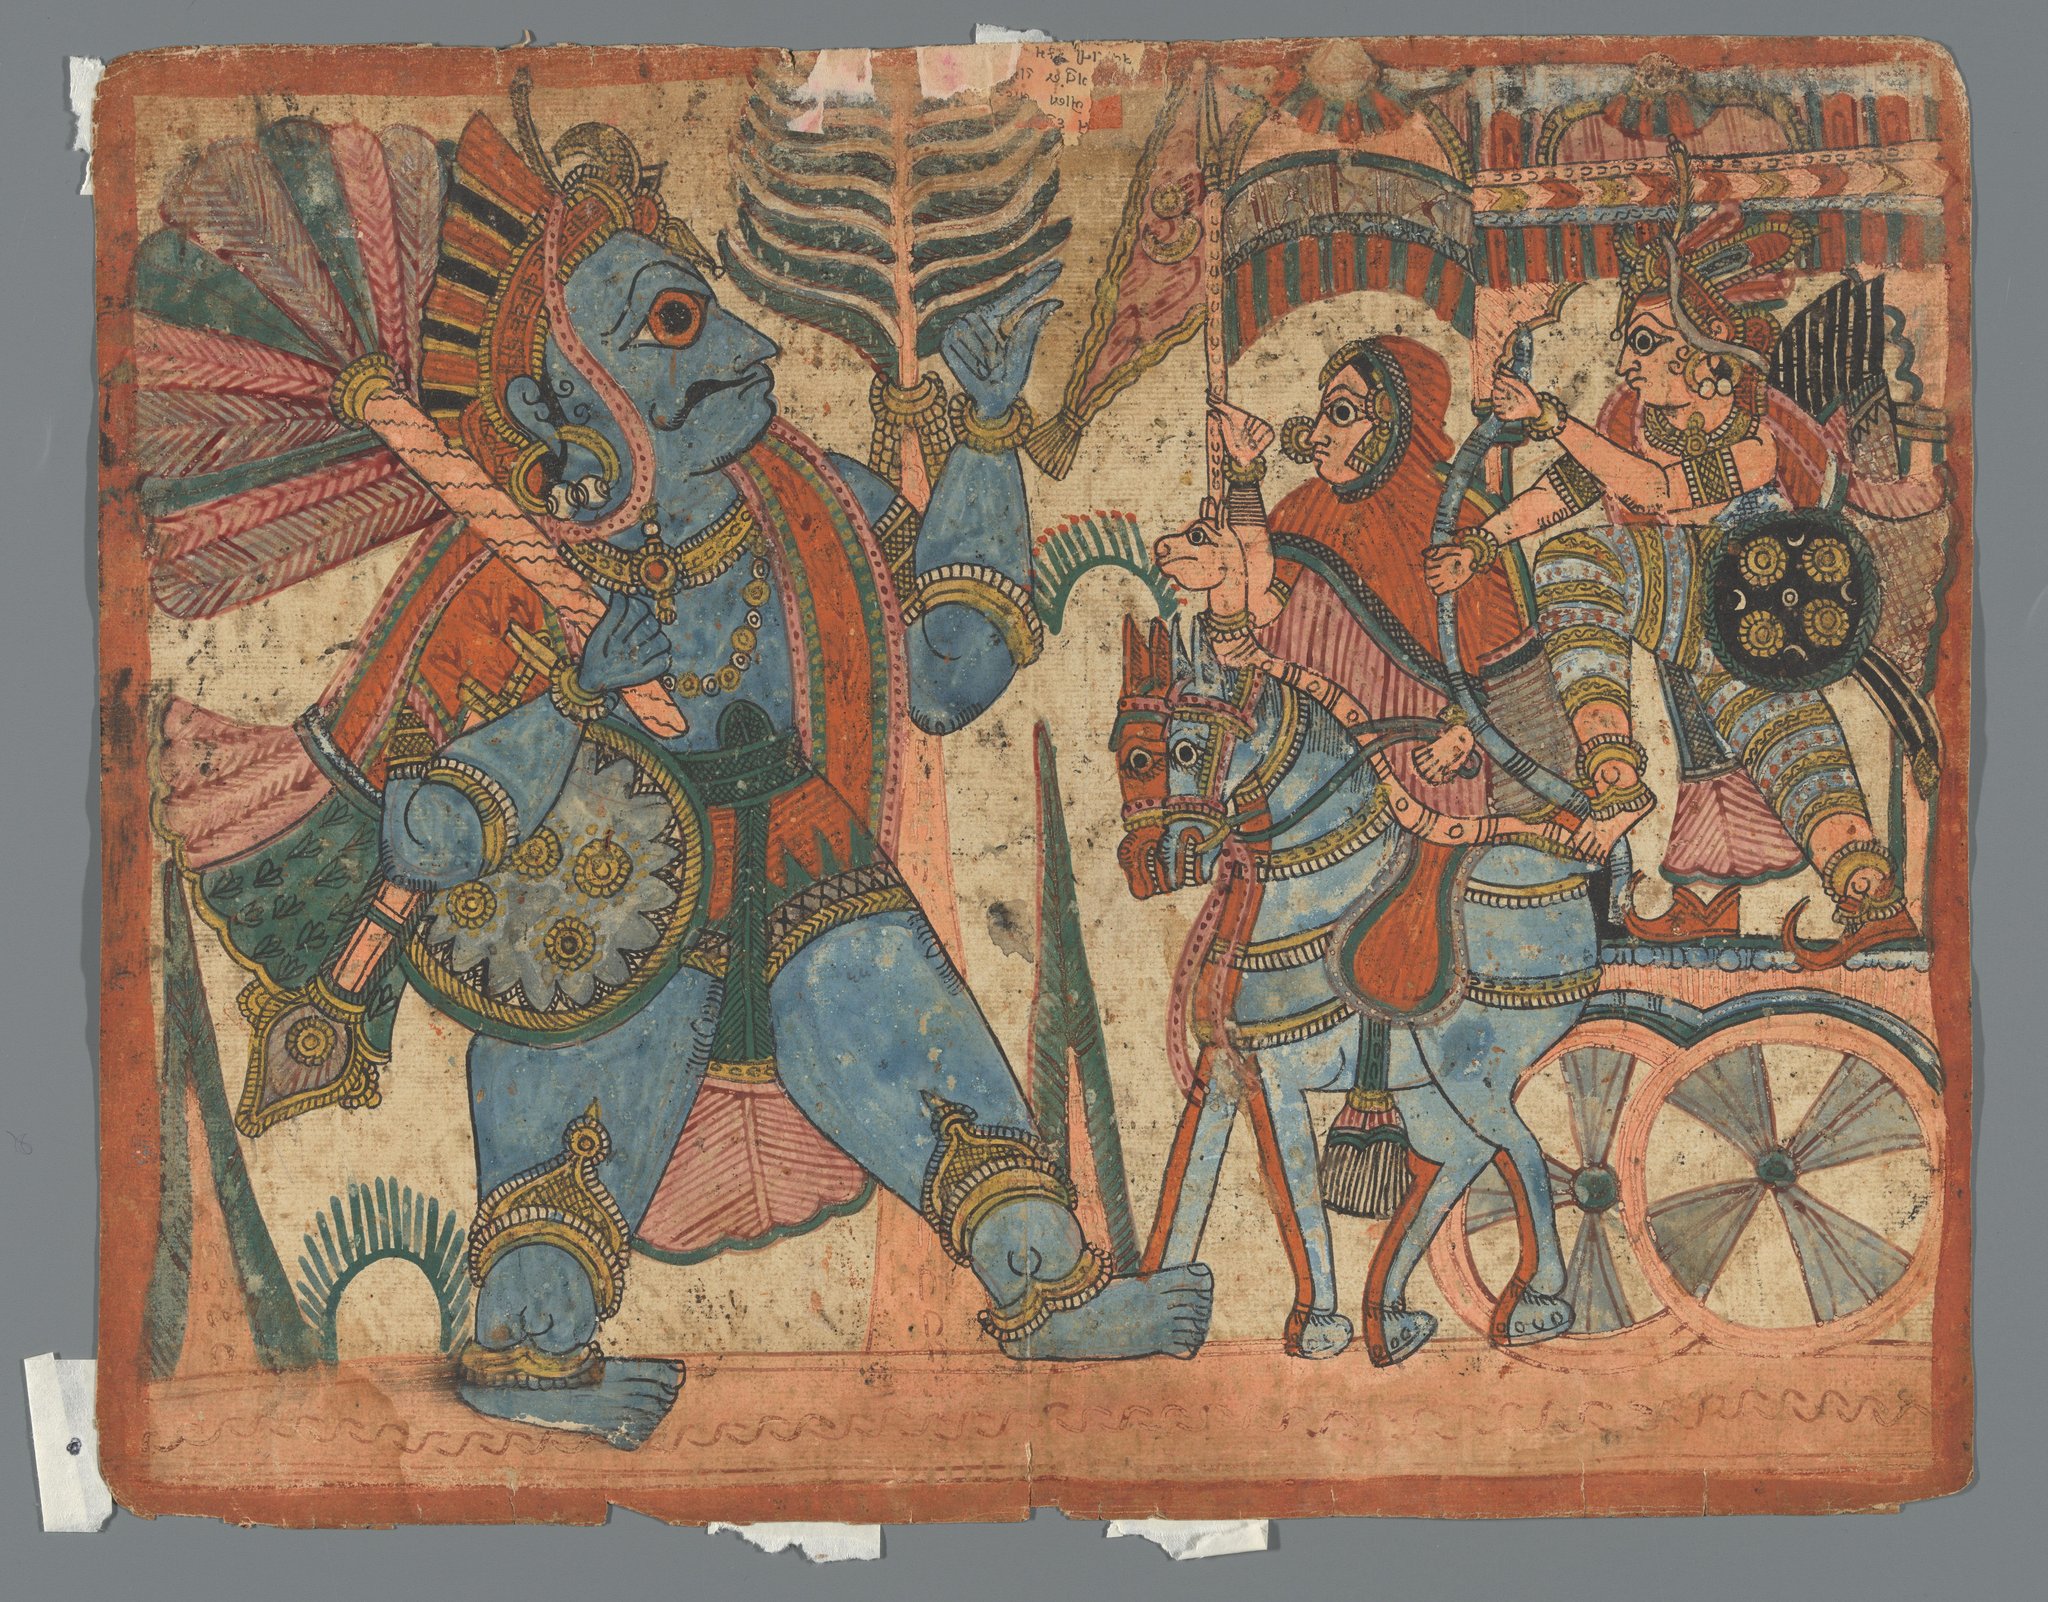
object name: indian miniature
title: ‘Paithan’ (Chitrakathi) narrative painting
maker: Anonymous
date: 1800-1899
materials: paper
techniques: brush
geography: andhra pradesh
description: Abhimanyu (son of the Mahabharata-hero Arjuna) and his mother Subhadhra travel through the forest in a chariot. Their road is obstructed by the demon Ghatotkacha, son of Arjuna's brother Bhima. The heroes are unaware of their family ties and a fight arises. Scene from the story of the marriage of Abhimanyu and Vatsala. The story although connected to the events of the Mahabharata, is not found in the standard versions of the Epic and is probably based on local tradition, in Kannada or Marathi, either written or oral.